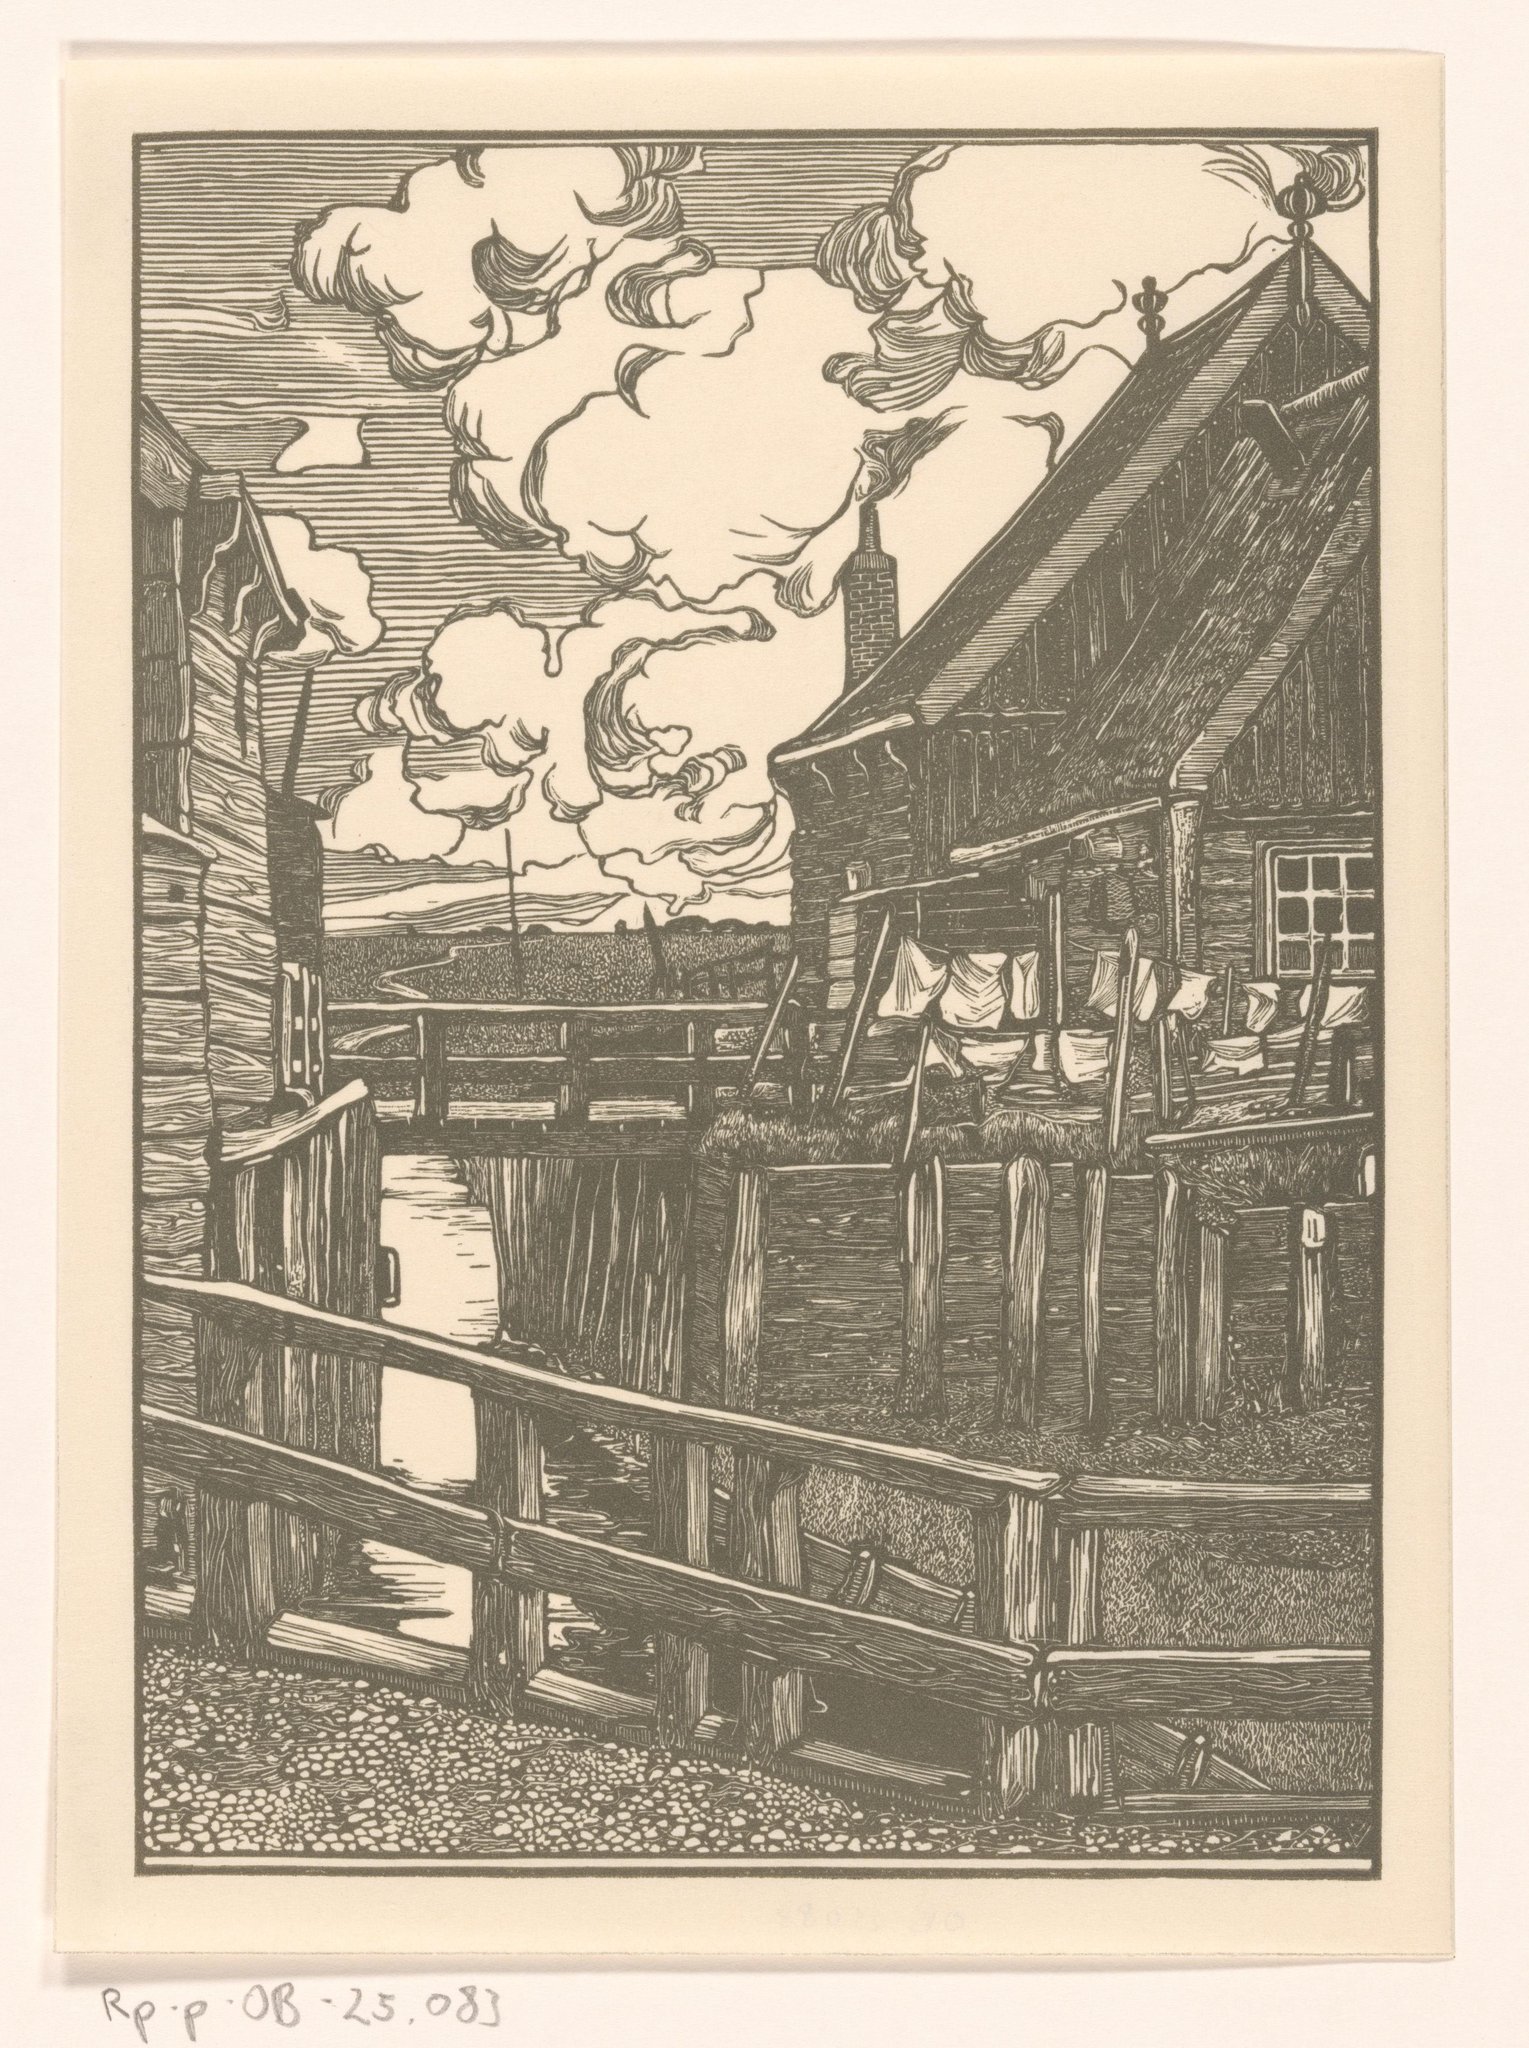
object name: print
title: Sloot en huizen aan een weiland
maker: jacobus gerardus veldheer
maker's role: draughtsman, print maker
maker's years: 1866-1954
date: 1876-1954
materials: paper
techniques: woodcut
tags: rural housing, e.g. country-house, villa, cottage, small canal, ditch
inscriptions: collector's mark: Lugt 2228